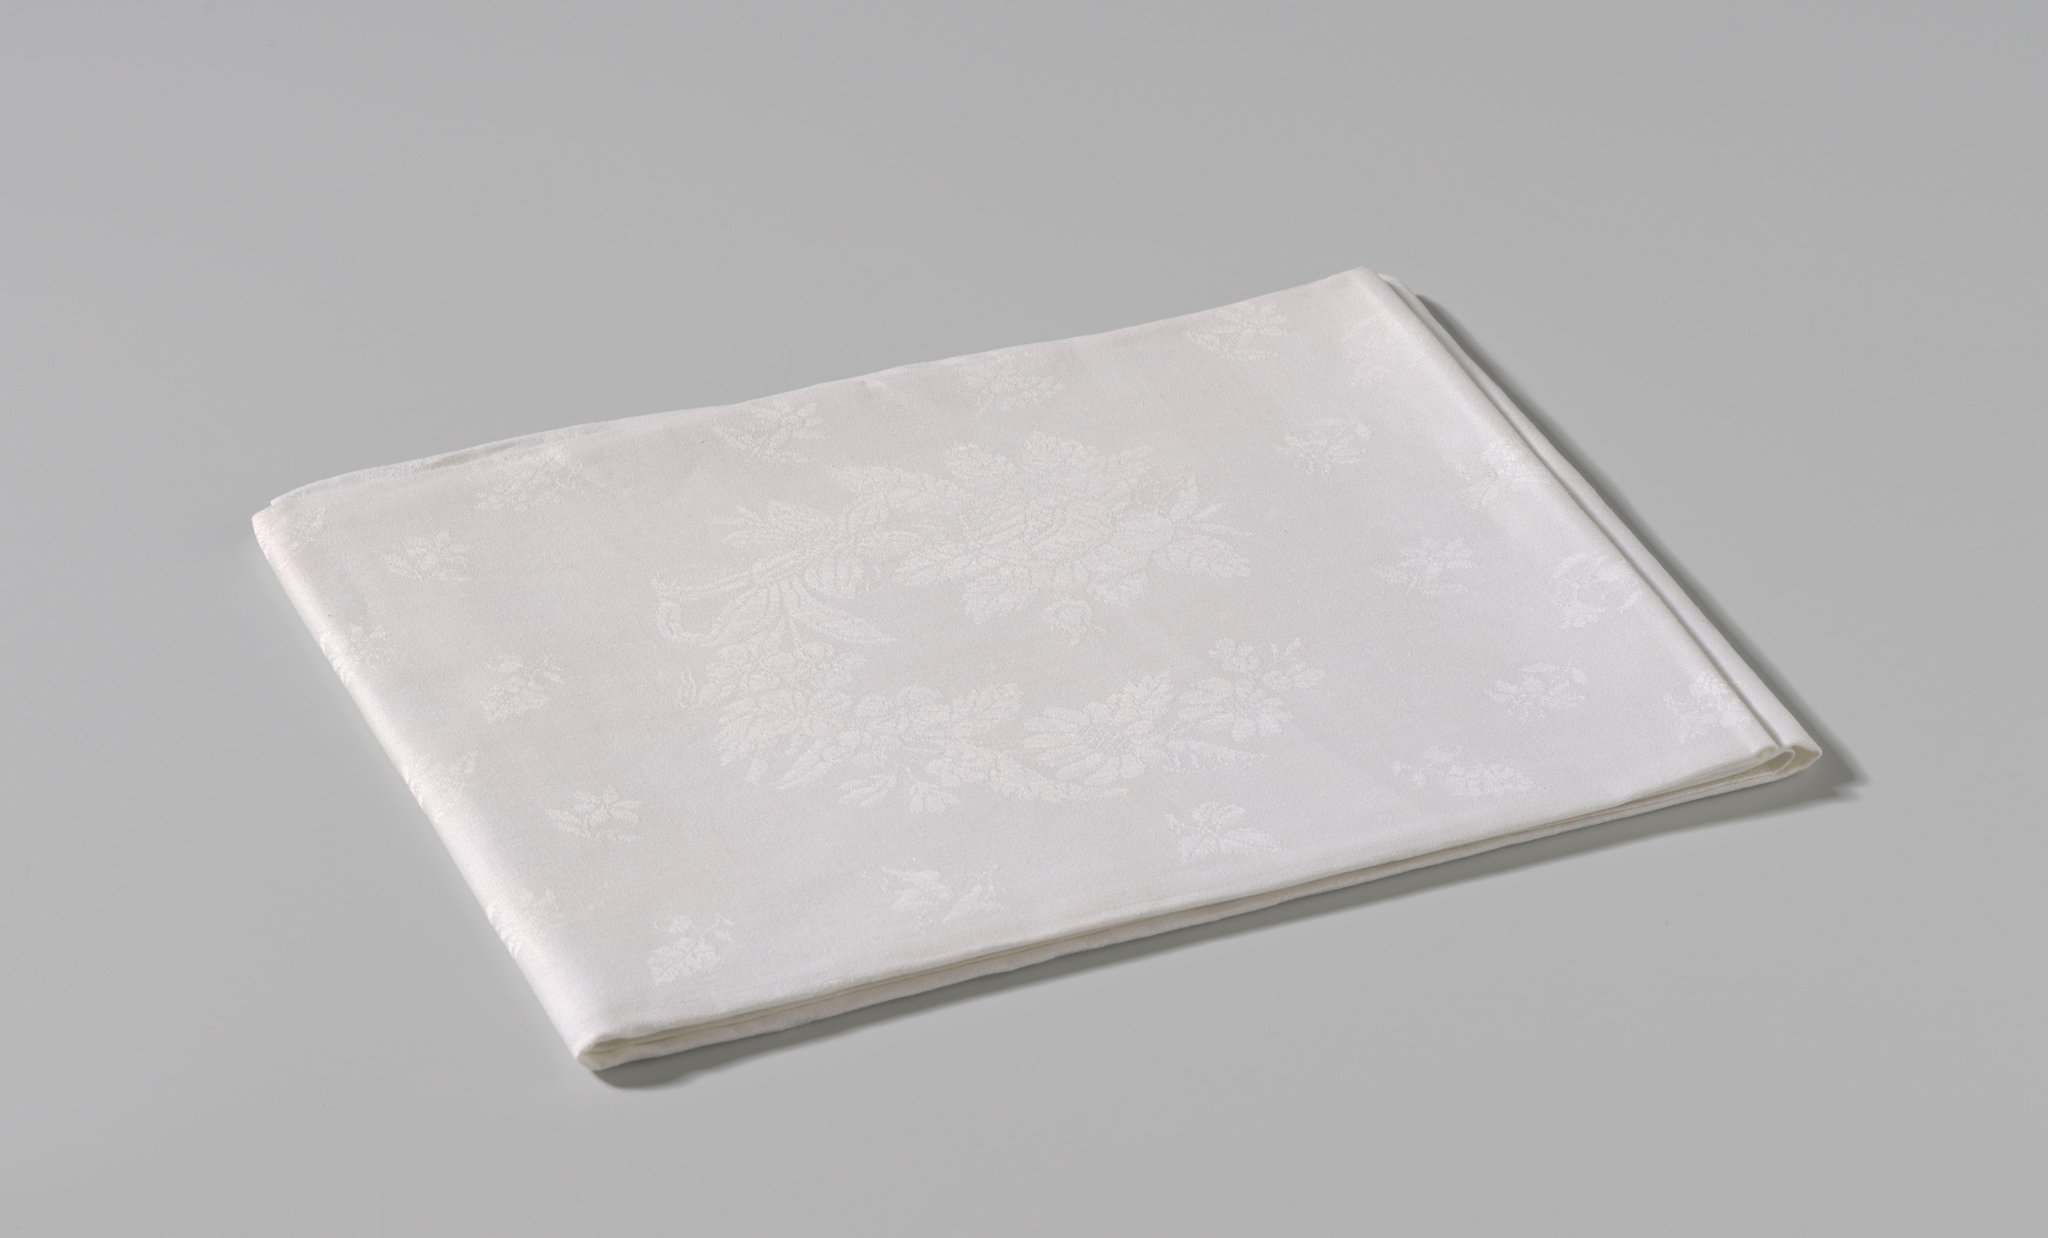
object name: napkin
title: Servet van linnendamast met een bloempatroon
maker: Anonymous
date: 1800-1850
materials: linen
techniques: damask, weave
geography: netherlands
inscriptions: mark: ‘.L.’, mark: ‘BG 24’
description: Servet van linnendamast met een bloempatroon. Middenveld met strooimotieven, liggende en lopende randen, respectievelijk bloemmotieven en bladrand en liggende rand met dambordmotief. Het servet hoort bij zeven servetten (BK-1976-121-A t/m BK-1976-121-H) en een tafellaken (BK-1976-120).